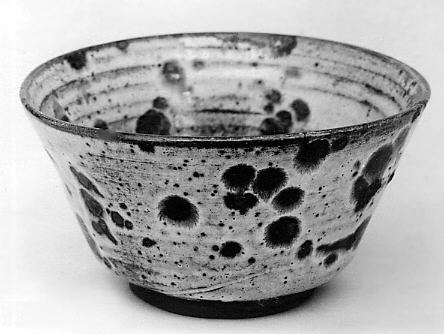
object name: teabowl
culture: japanese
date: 1801-1900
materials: clay, glaze